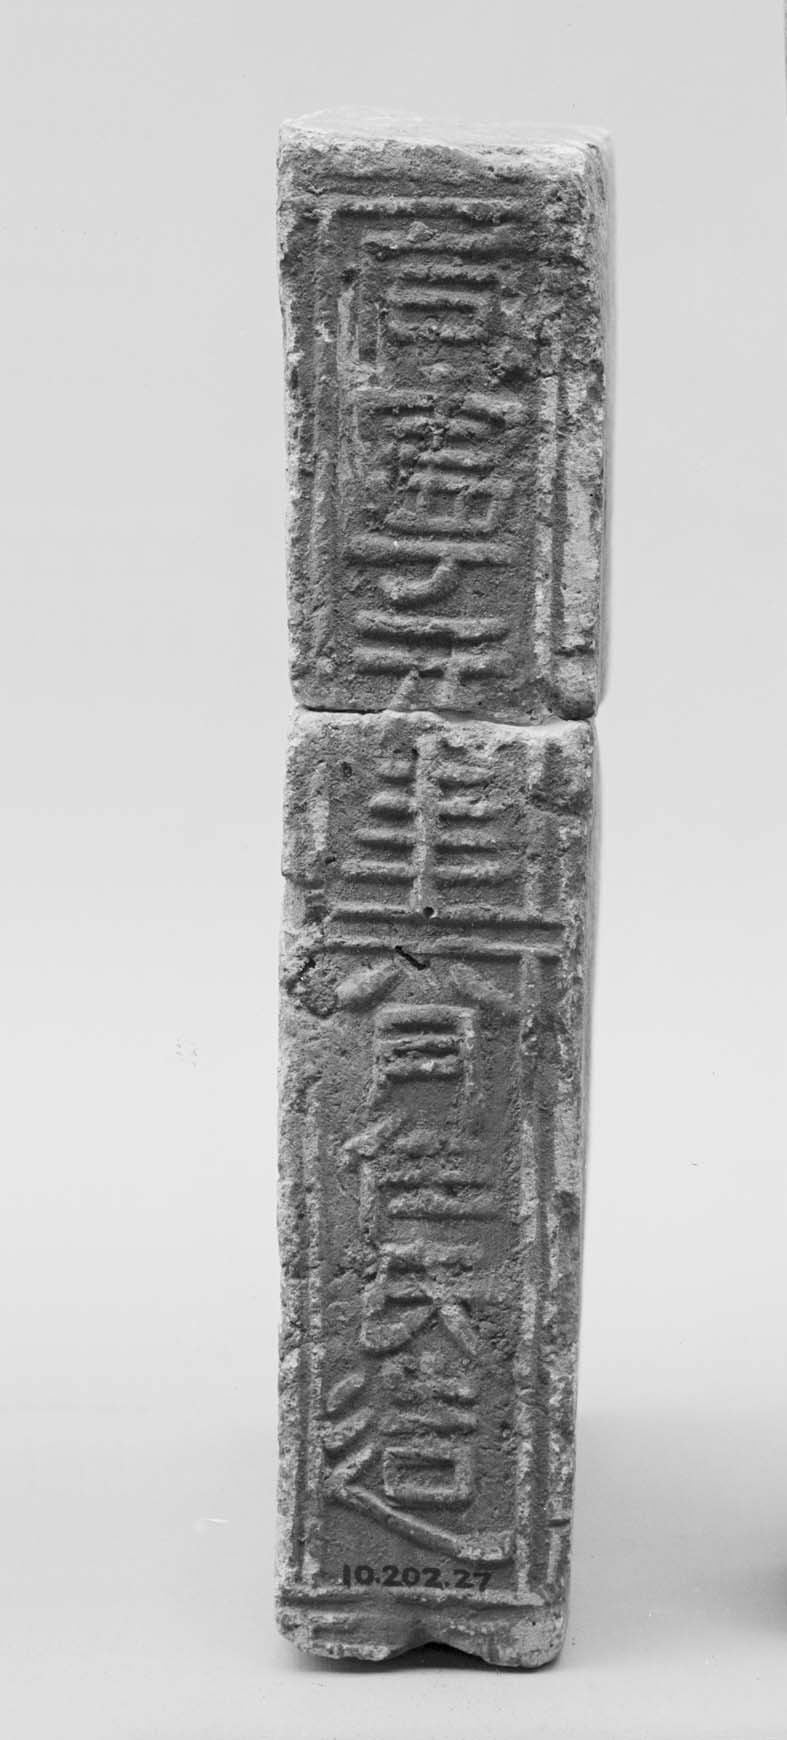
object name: tile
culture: chinese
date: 221 BCE-220 CE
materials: earthenware